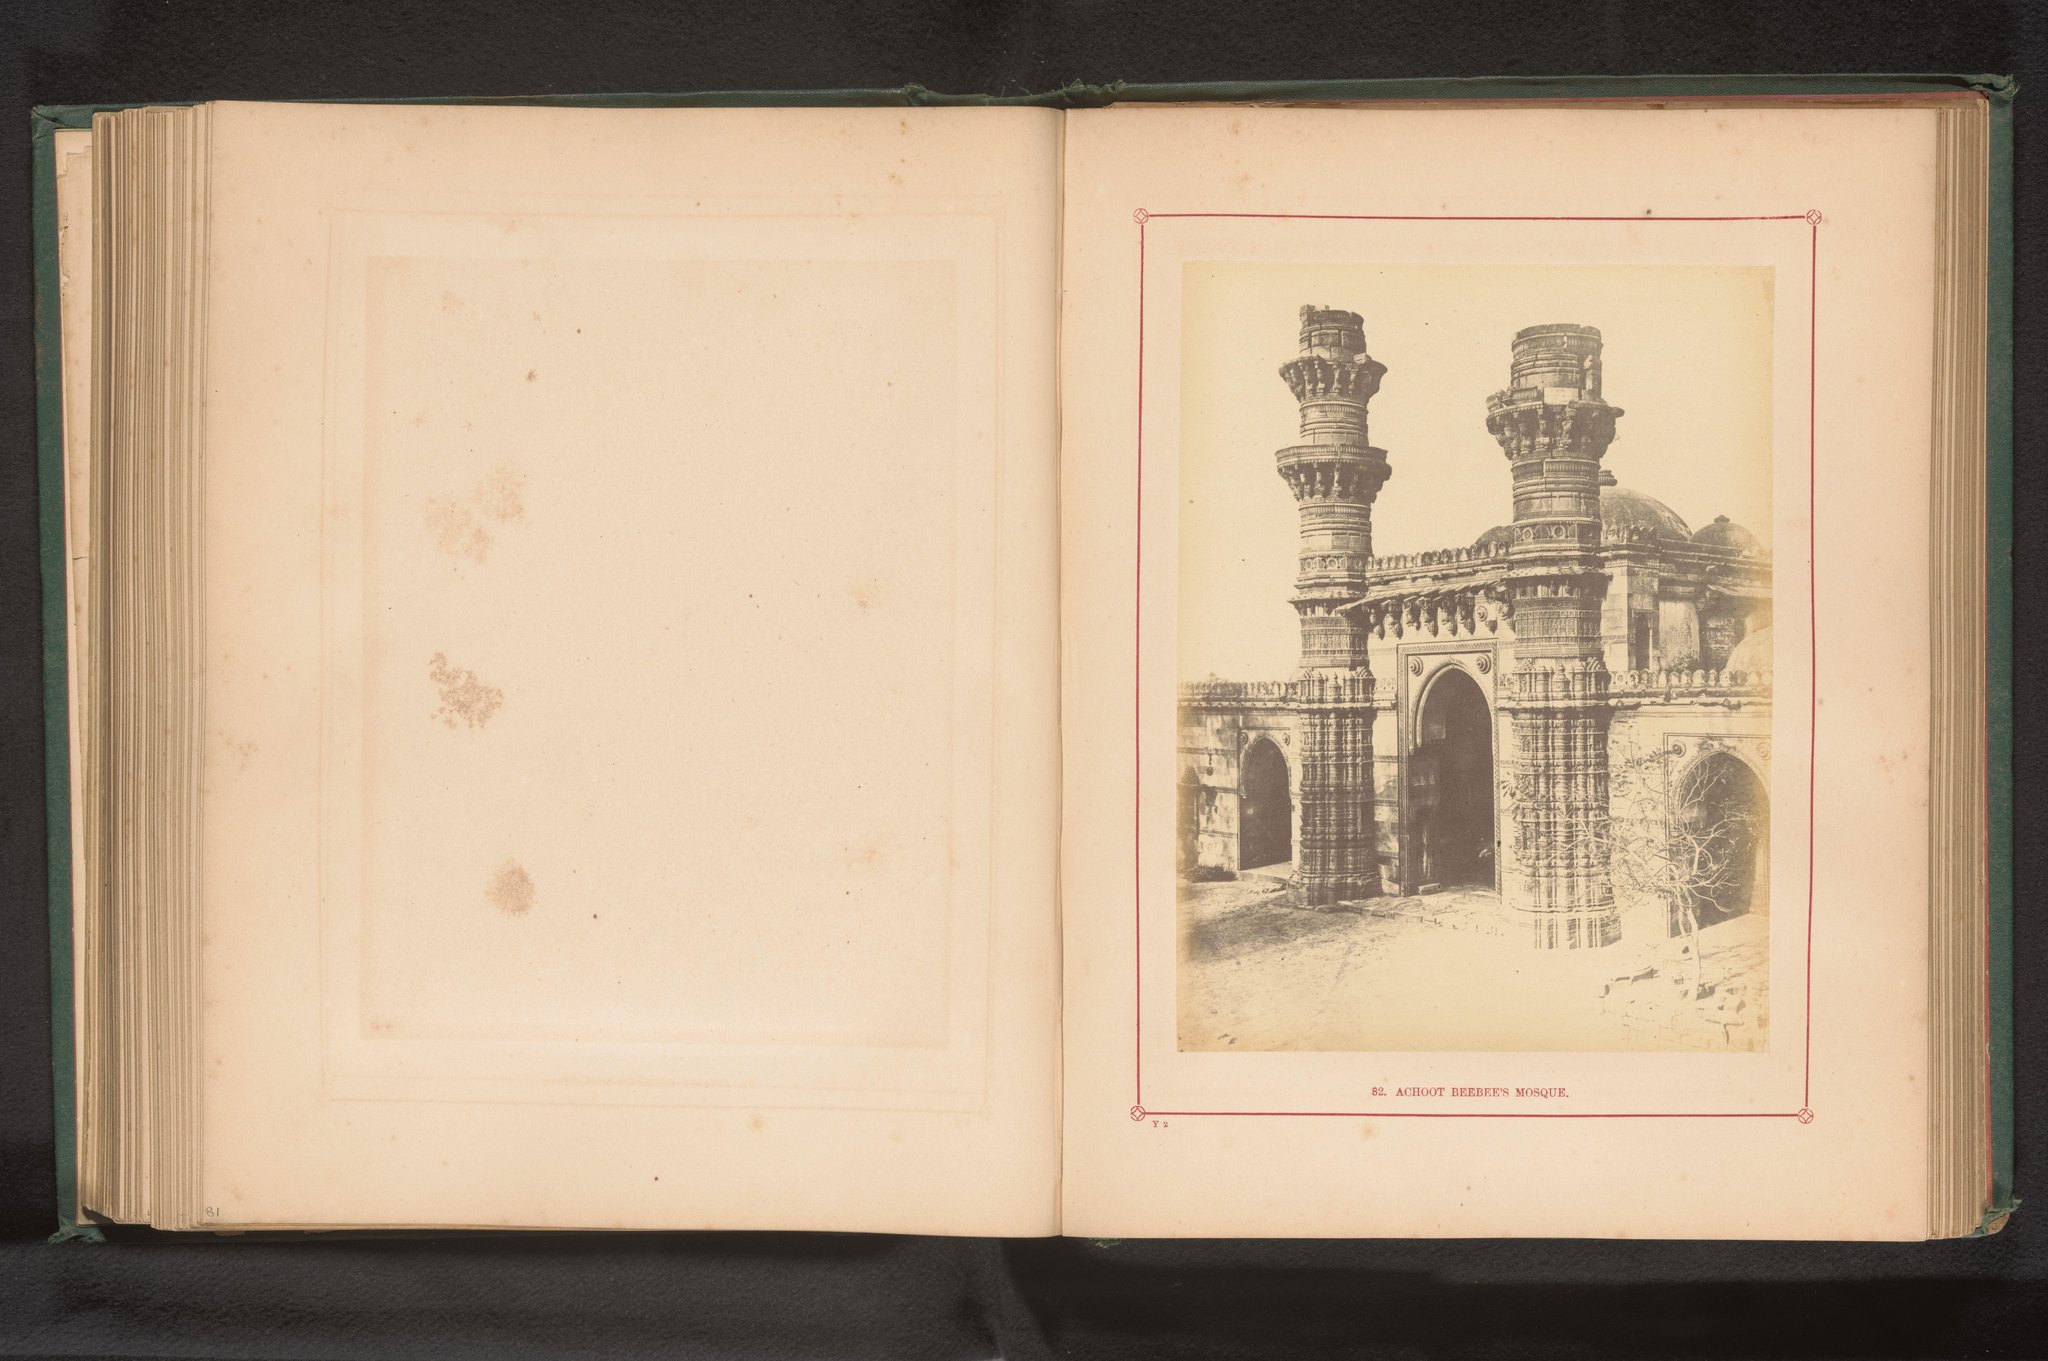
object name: page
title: Gezicht op de Achut Bibi-moskee in Ahmedabad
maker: thomas biggs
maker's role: fotograaf, kapitein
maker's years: 1822-1905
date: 1856-1866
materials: photographic support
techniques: albumen print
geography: ahmedabad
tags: temple, shrine ~ islam, mohammedanism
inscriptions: inscription: ‘Y2’, number: ‘82.’